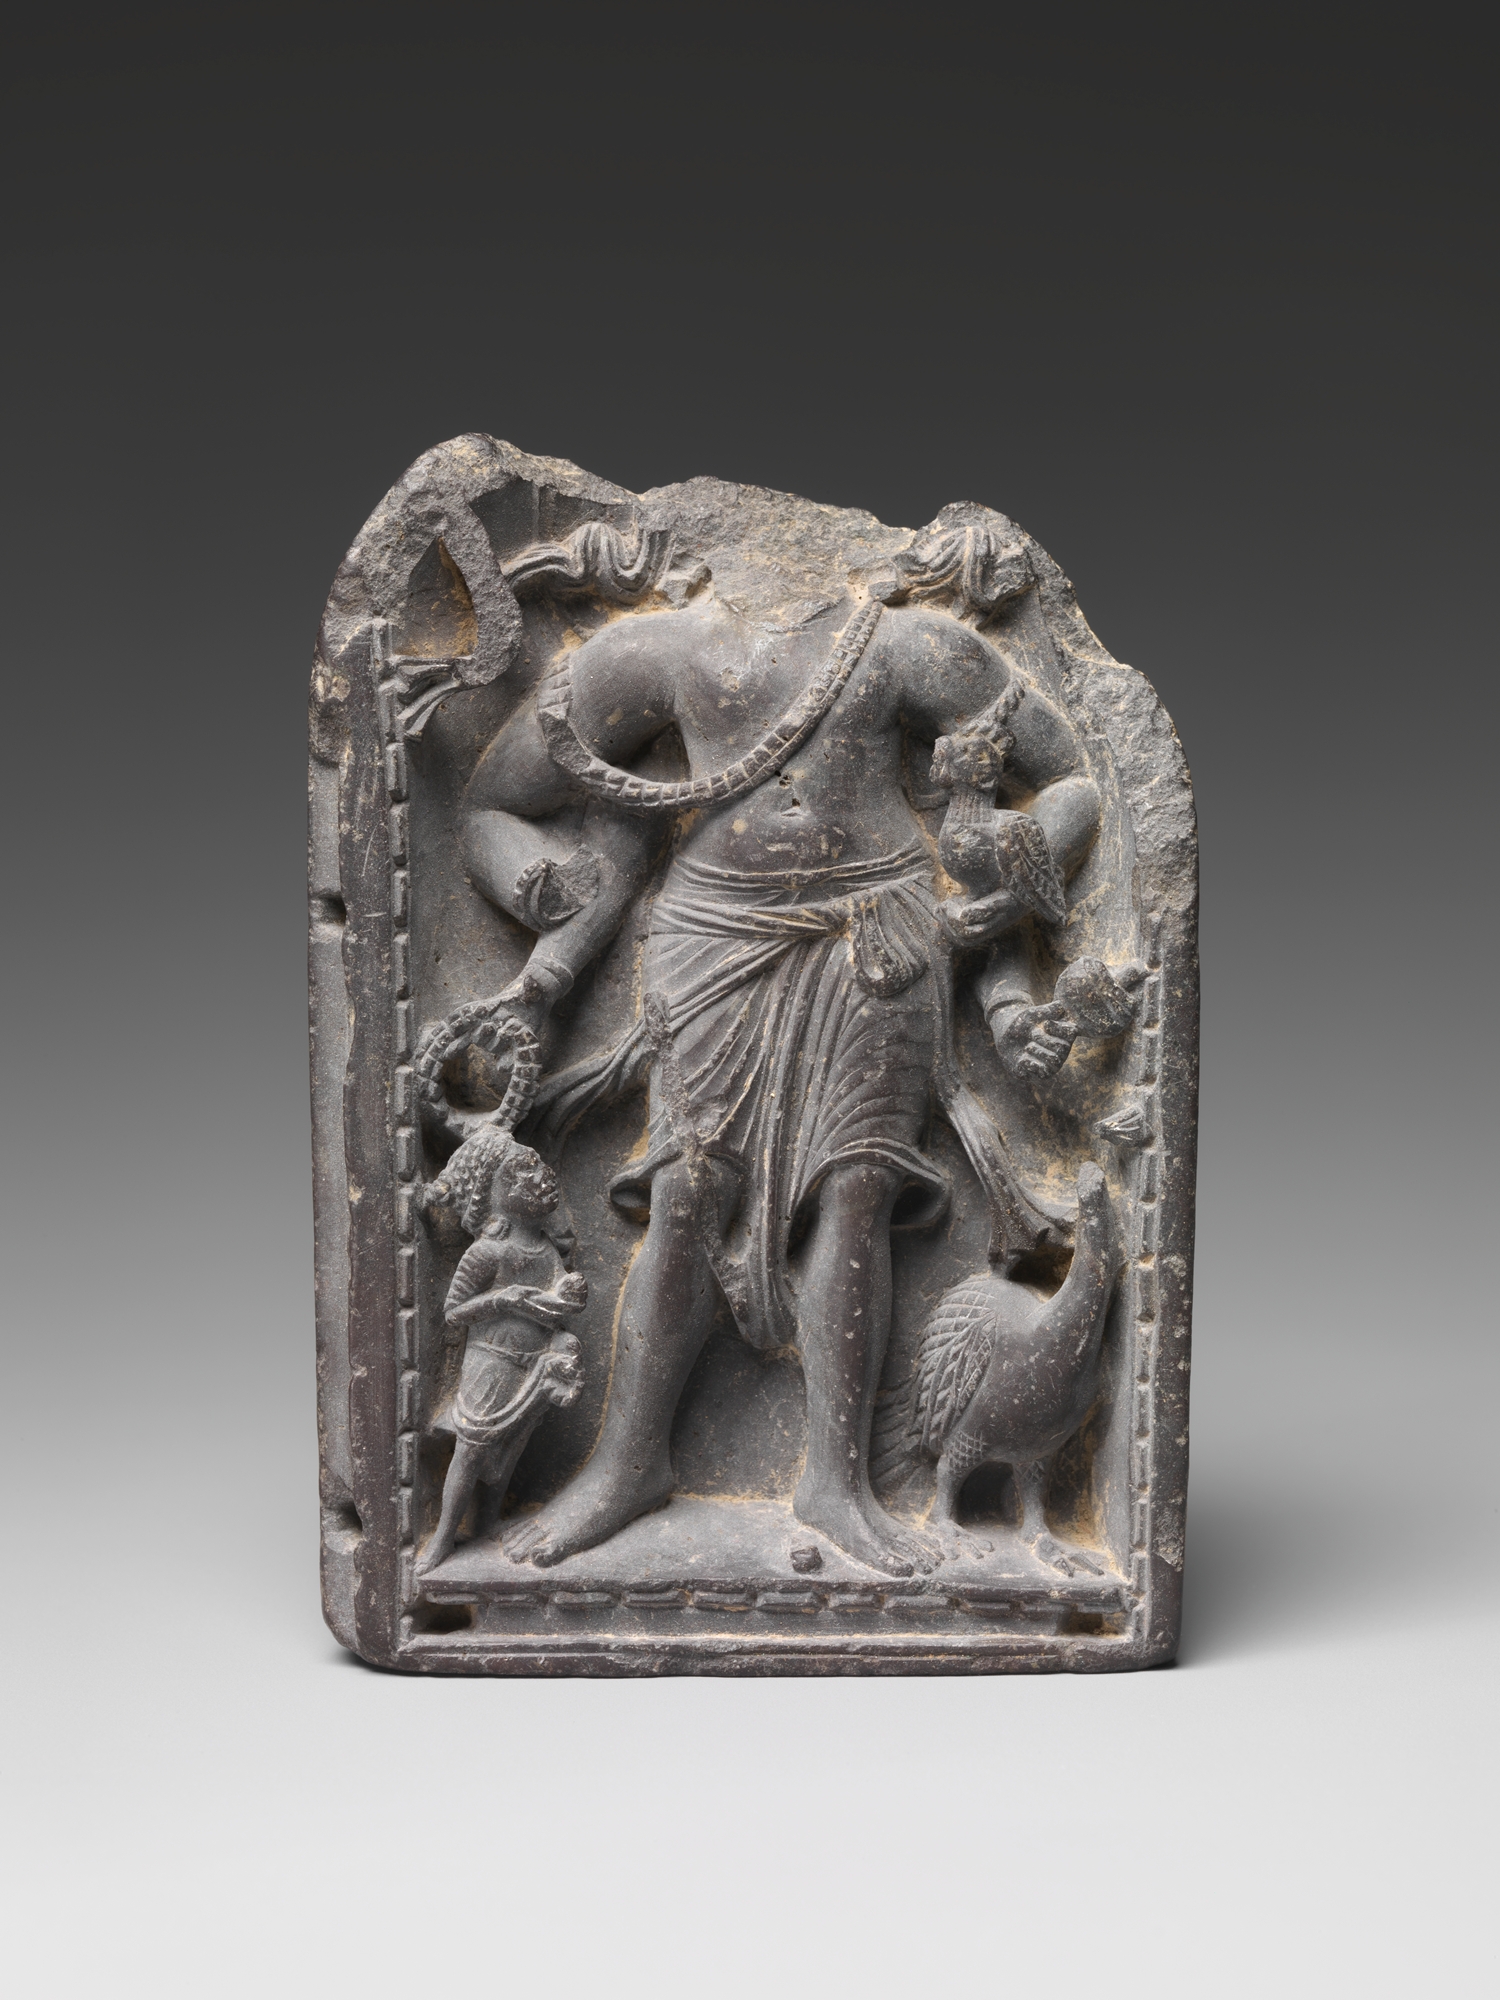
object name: figure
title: Panel of a Portable Shrine with Karttikeya, the God of War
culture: gandhara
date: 501-600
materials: stone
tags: kashmir,men,peacocks